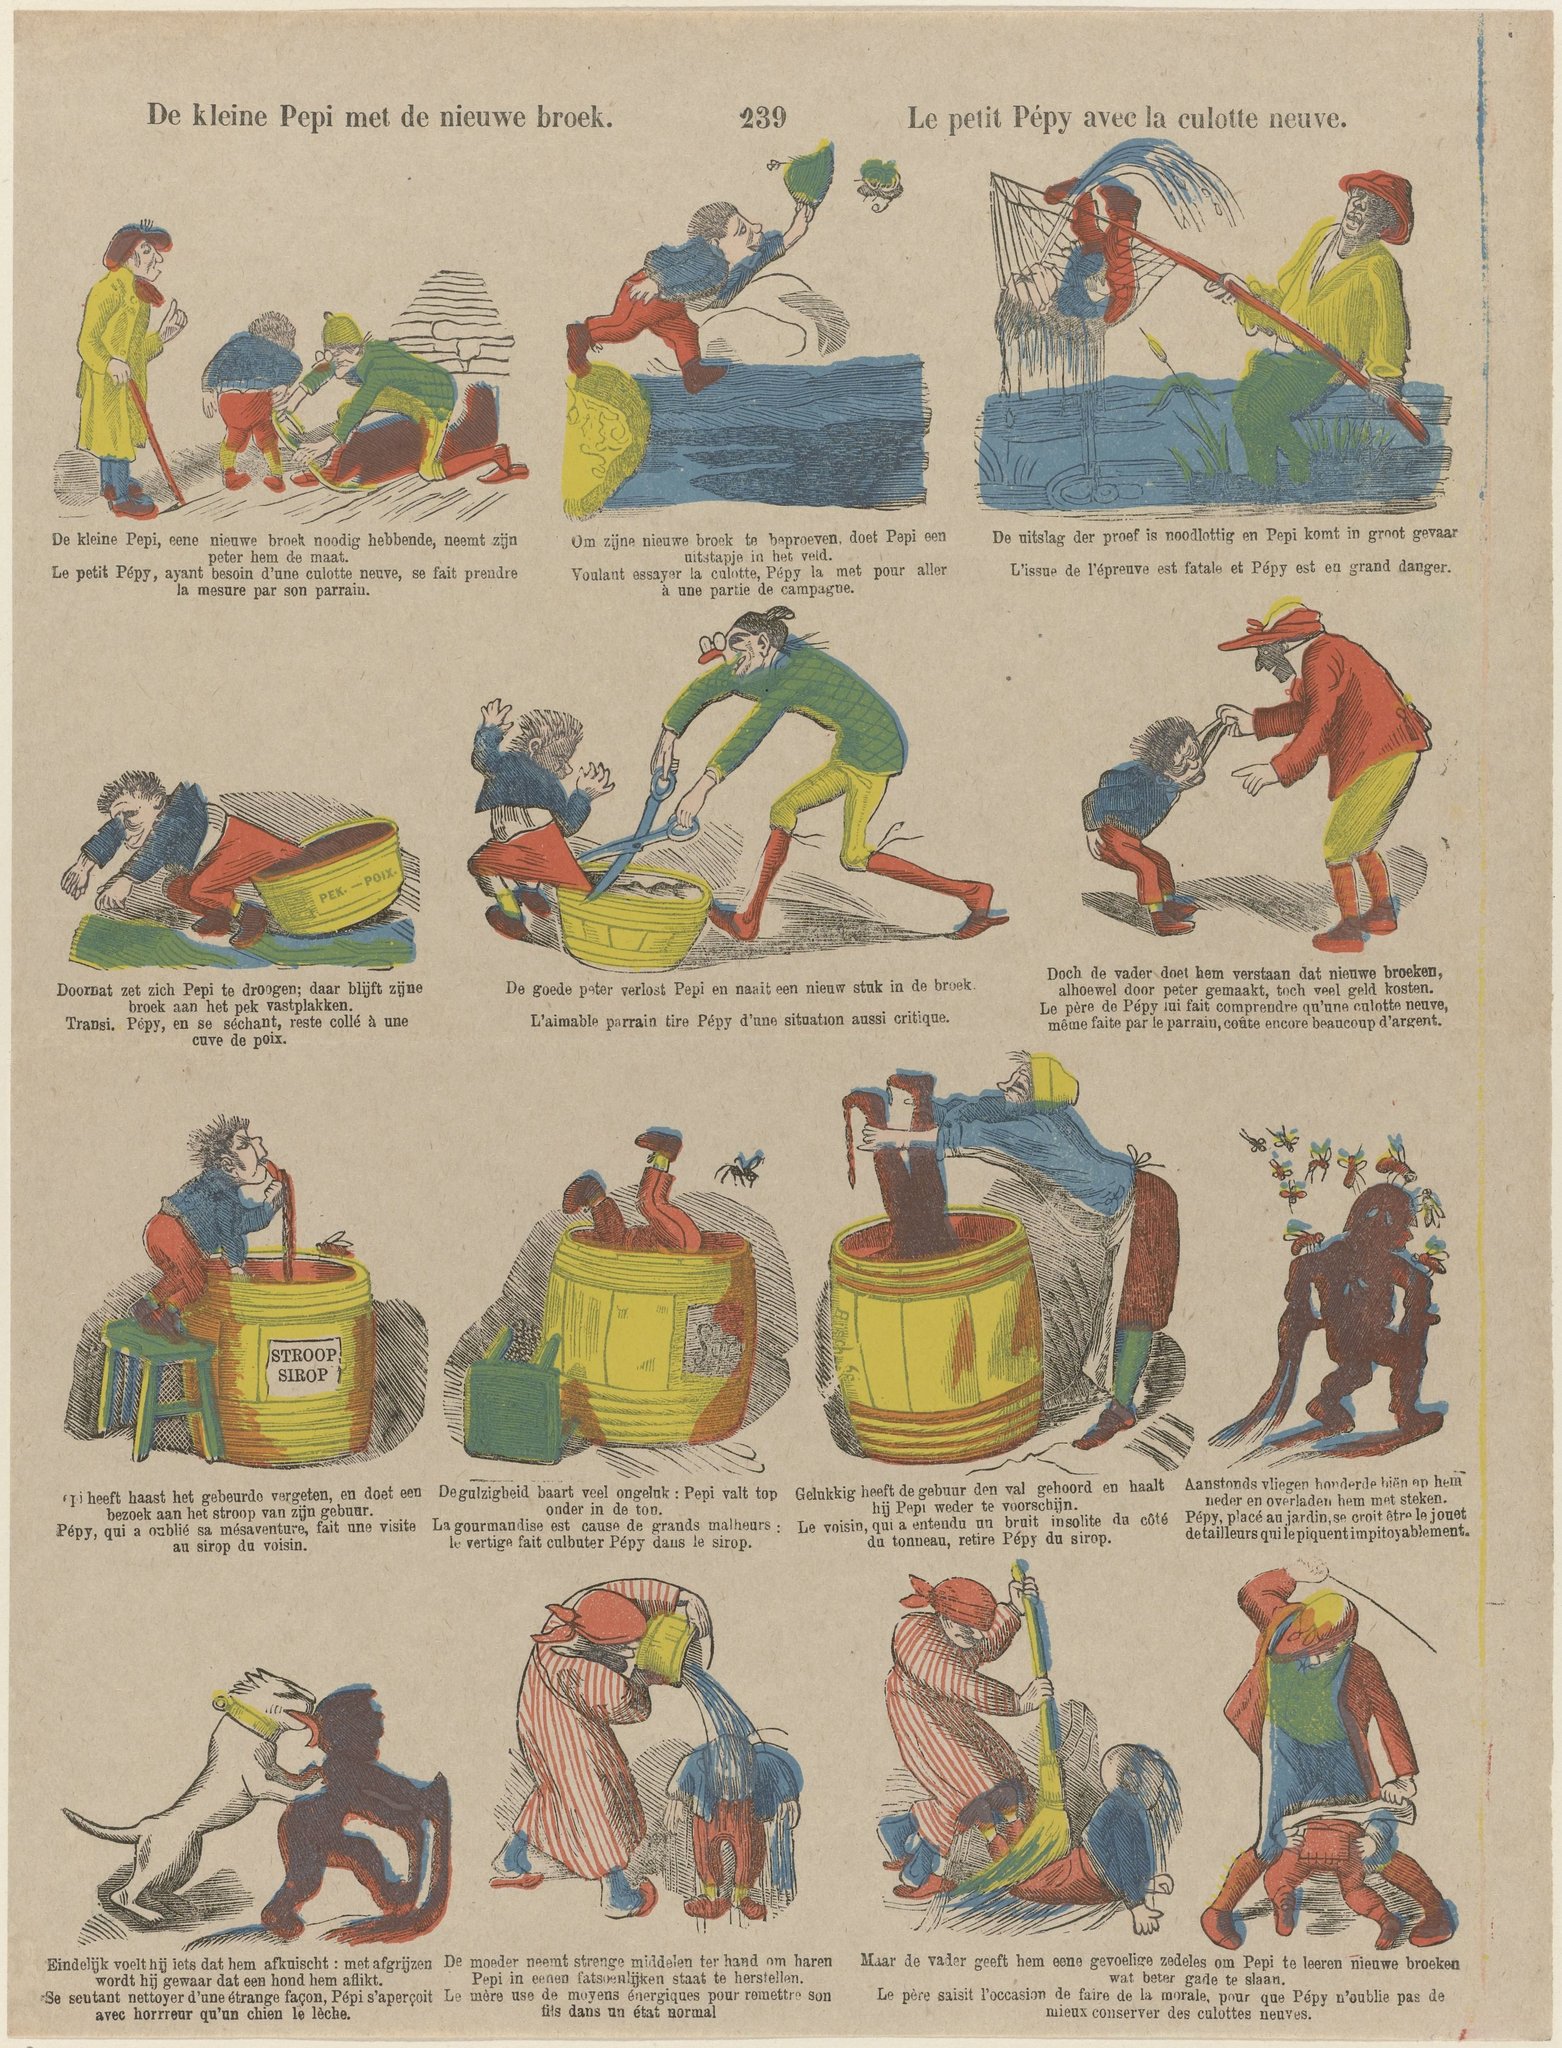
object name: print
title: De kleine Pepi met de nieuwe broek / Le petit Pépy avec la culotte neuve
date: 1833-1911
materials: paper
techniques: lithograph, letterpress printing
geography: turnhout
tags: mischief-making play, correction of naughty children, trousers, breeches, bad behaviour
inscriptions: collector's mark: Lugt 2760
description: Blad met 14 voorstellingen over Pepi die met zijn nieuwe broek allerlei kattenkwaad uithaalt en een pak slaag krijgt. Onder elke afbeelding een onderschrift in het Nederlands en in het Frans. Genummerd midden boven: 239.